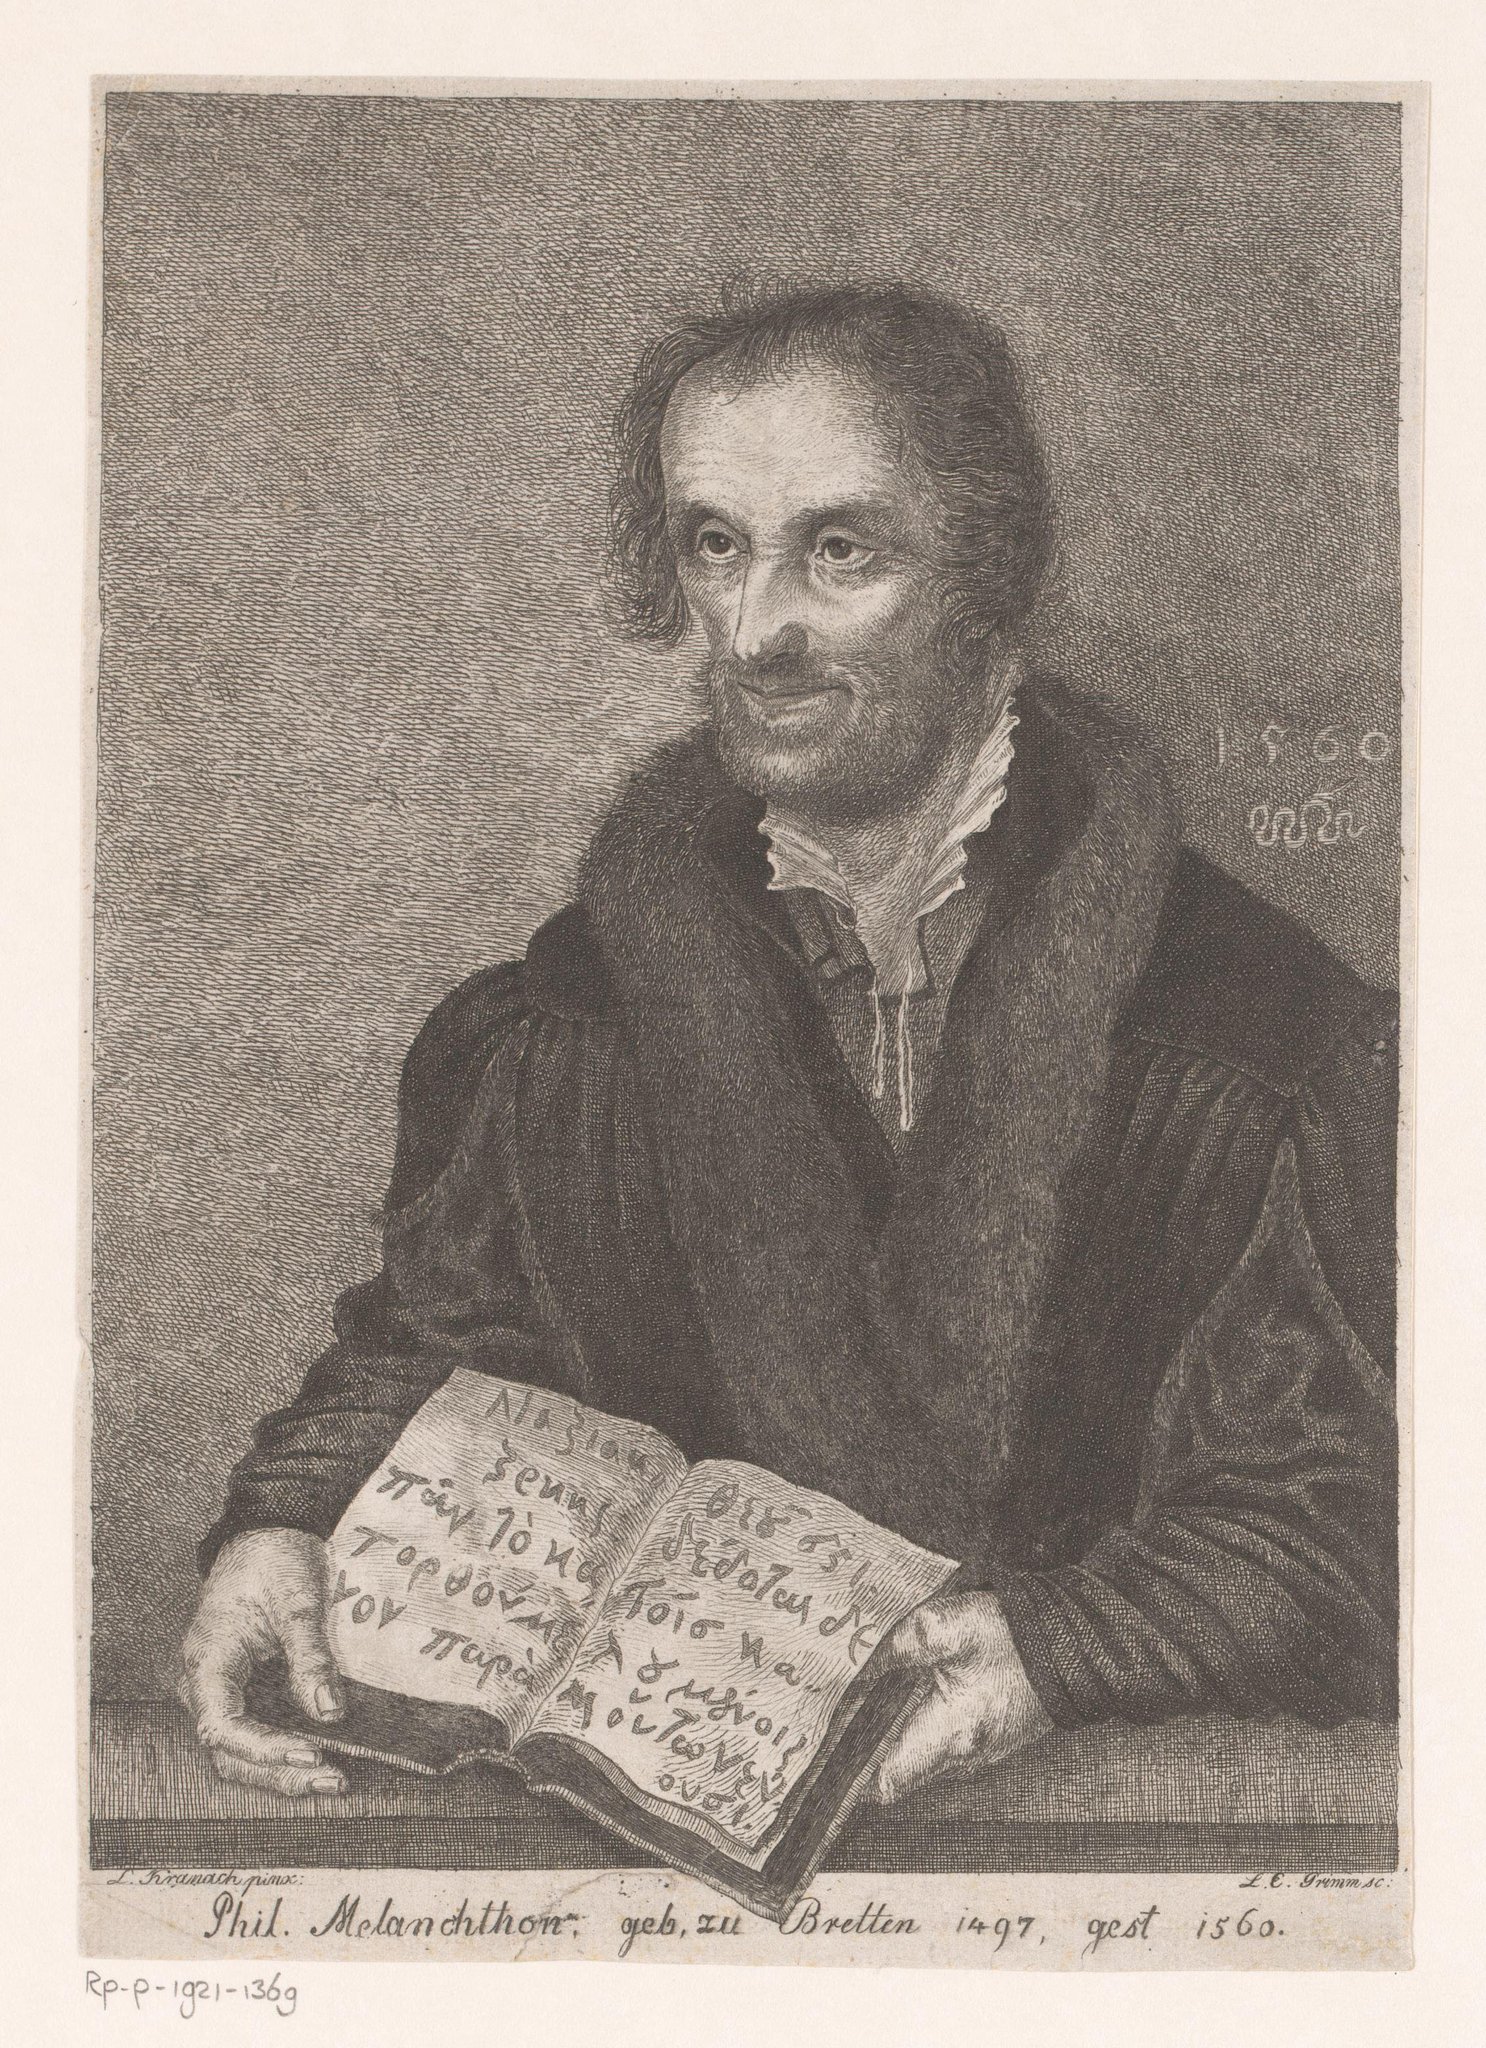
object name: print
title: Portret van Philipp Melanchton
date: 1800-1863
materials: paper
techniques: etching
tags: greek script, historical persons, book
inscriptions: collector's mark: Lugt 2233